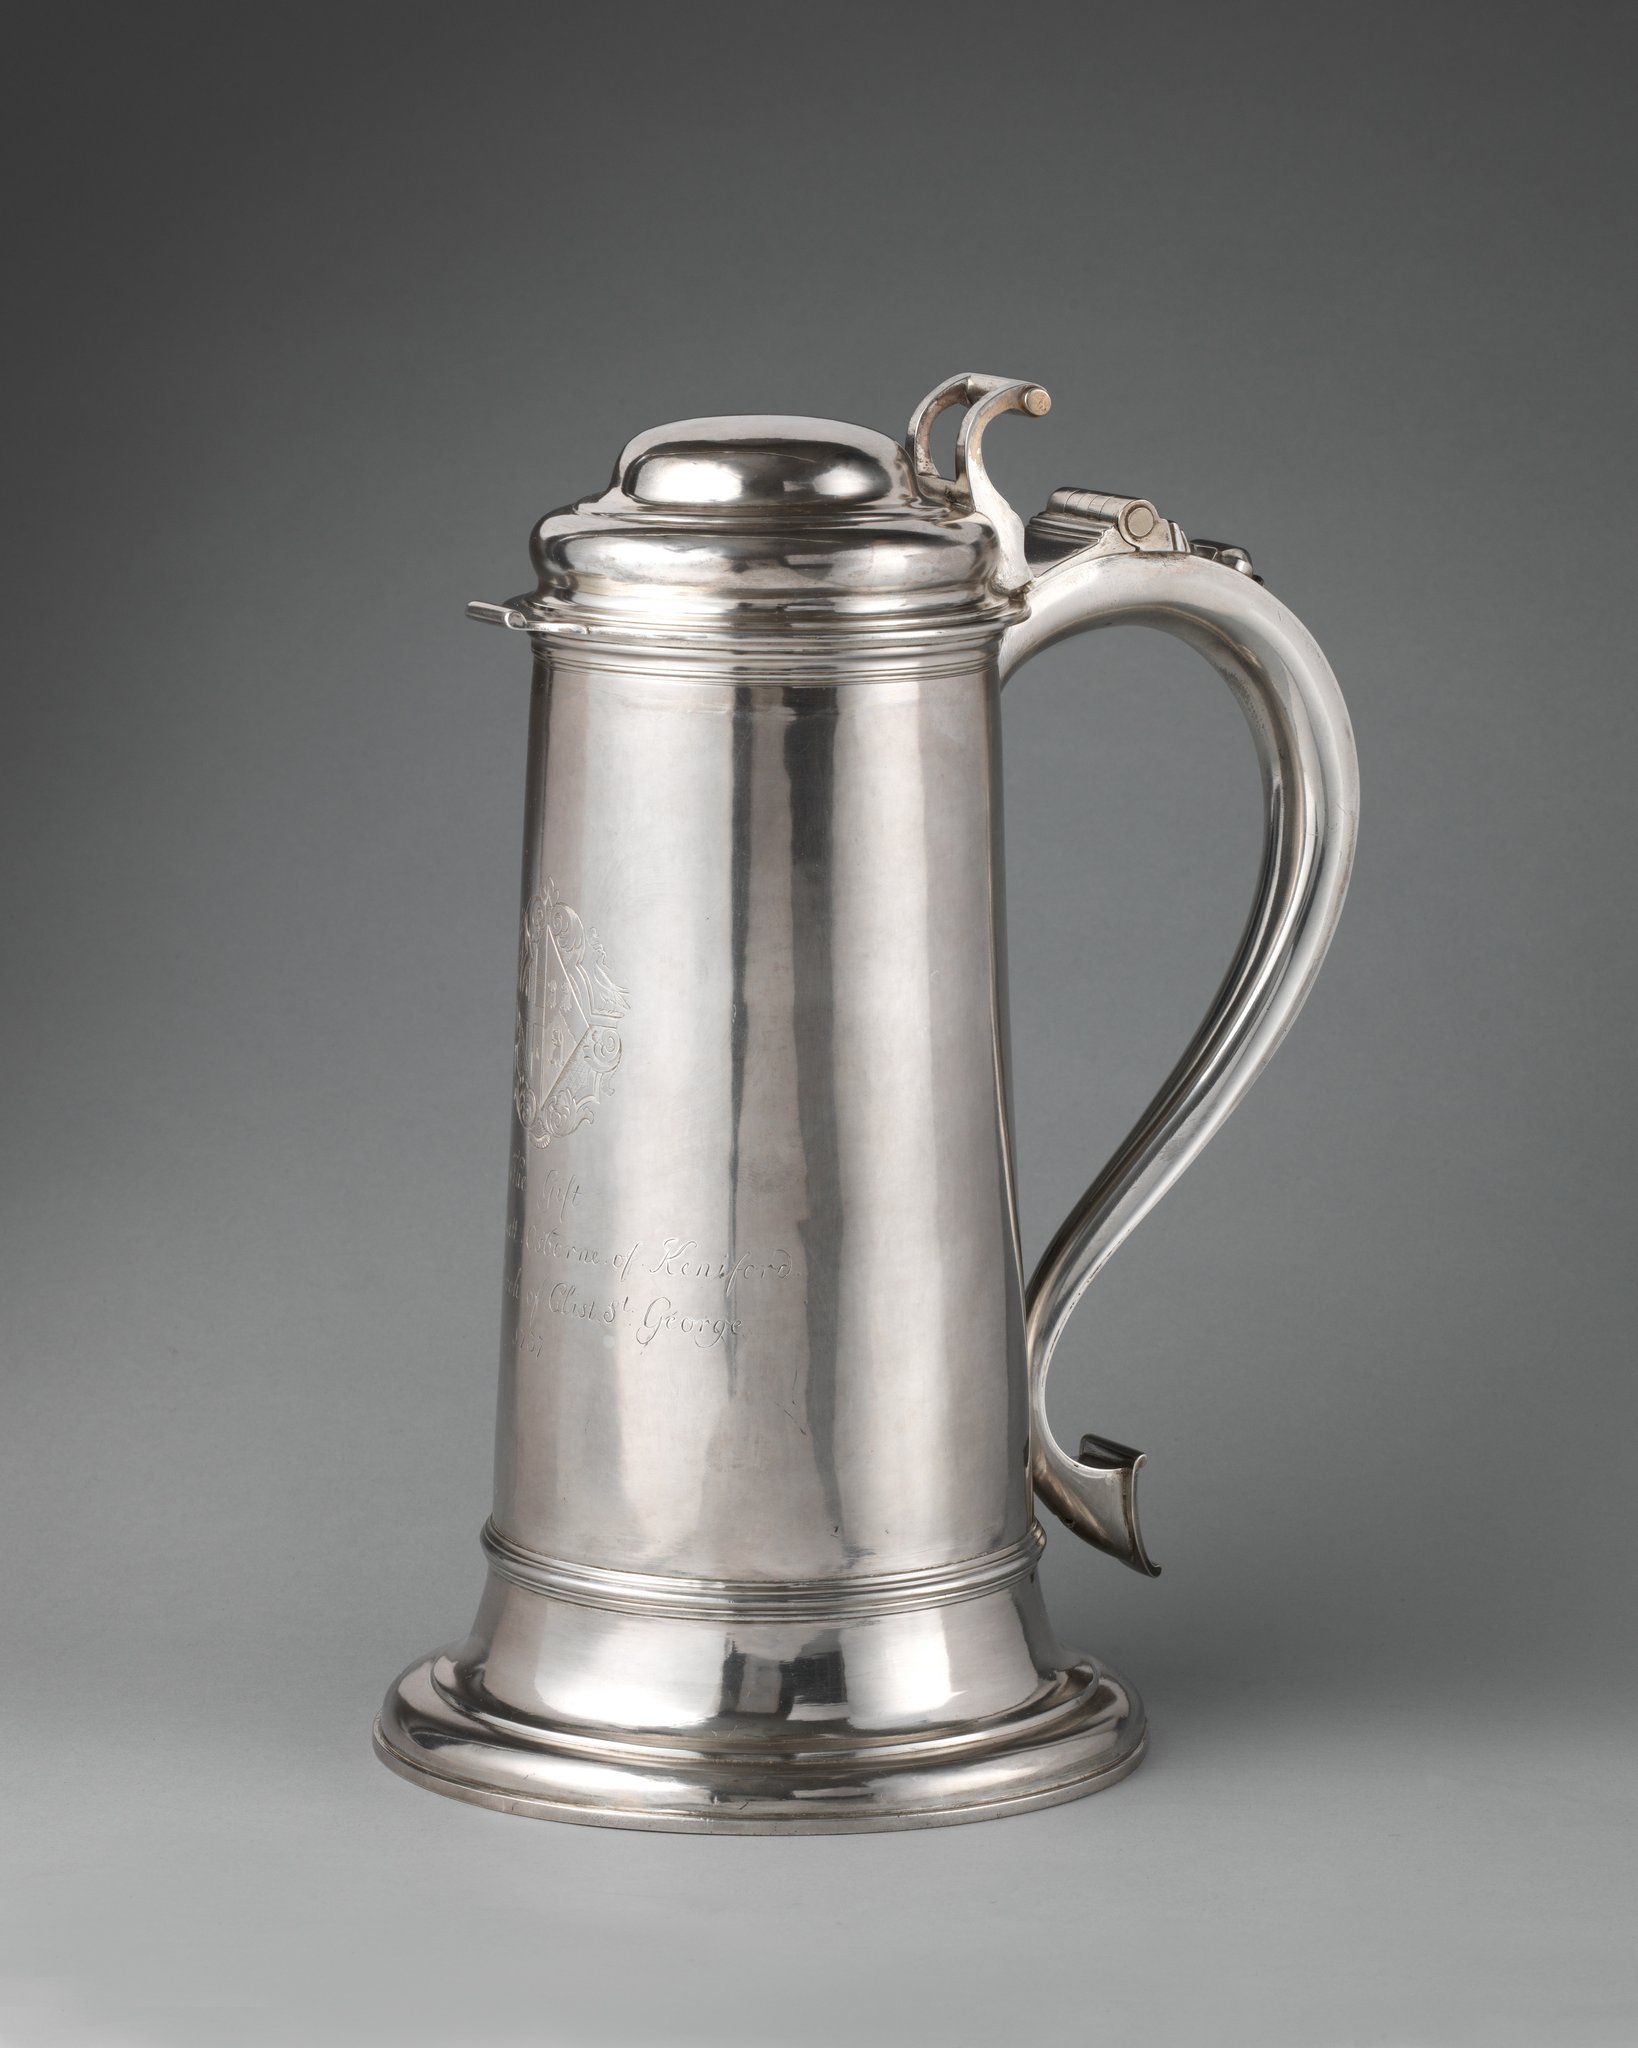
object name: communion flagon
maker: john webber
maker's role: maker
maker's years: 1700-1800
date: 1737-1738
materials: silver